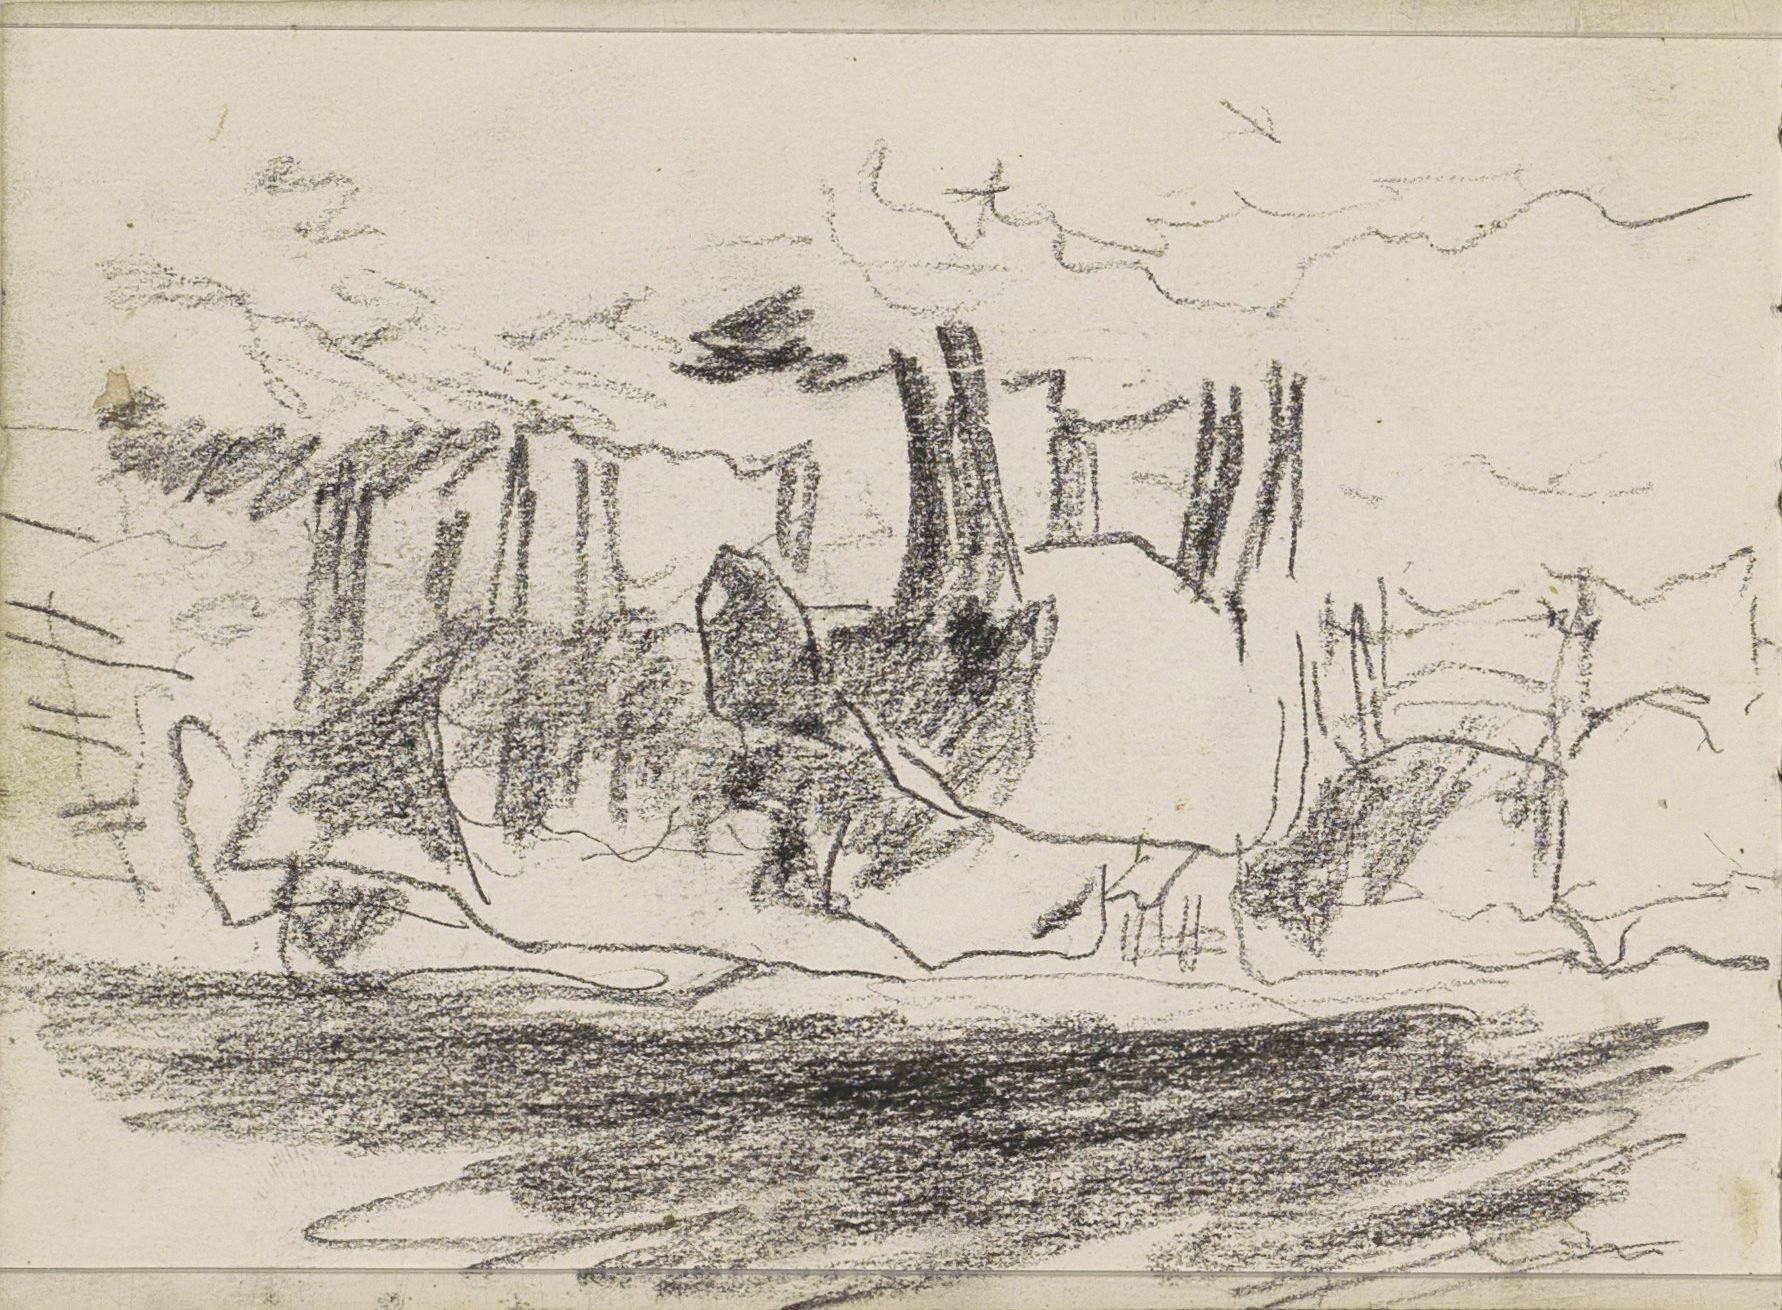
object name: sketchbook leaf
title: Koeien in een weiland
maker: anton mauve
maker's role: draughtsman, painter, print maker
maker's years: 1838-1888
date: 1848-1888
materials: chalk, paper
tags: cow, meadow, pasture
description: Blad 20 verso uit een schetsboek met 33 bladen.